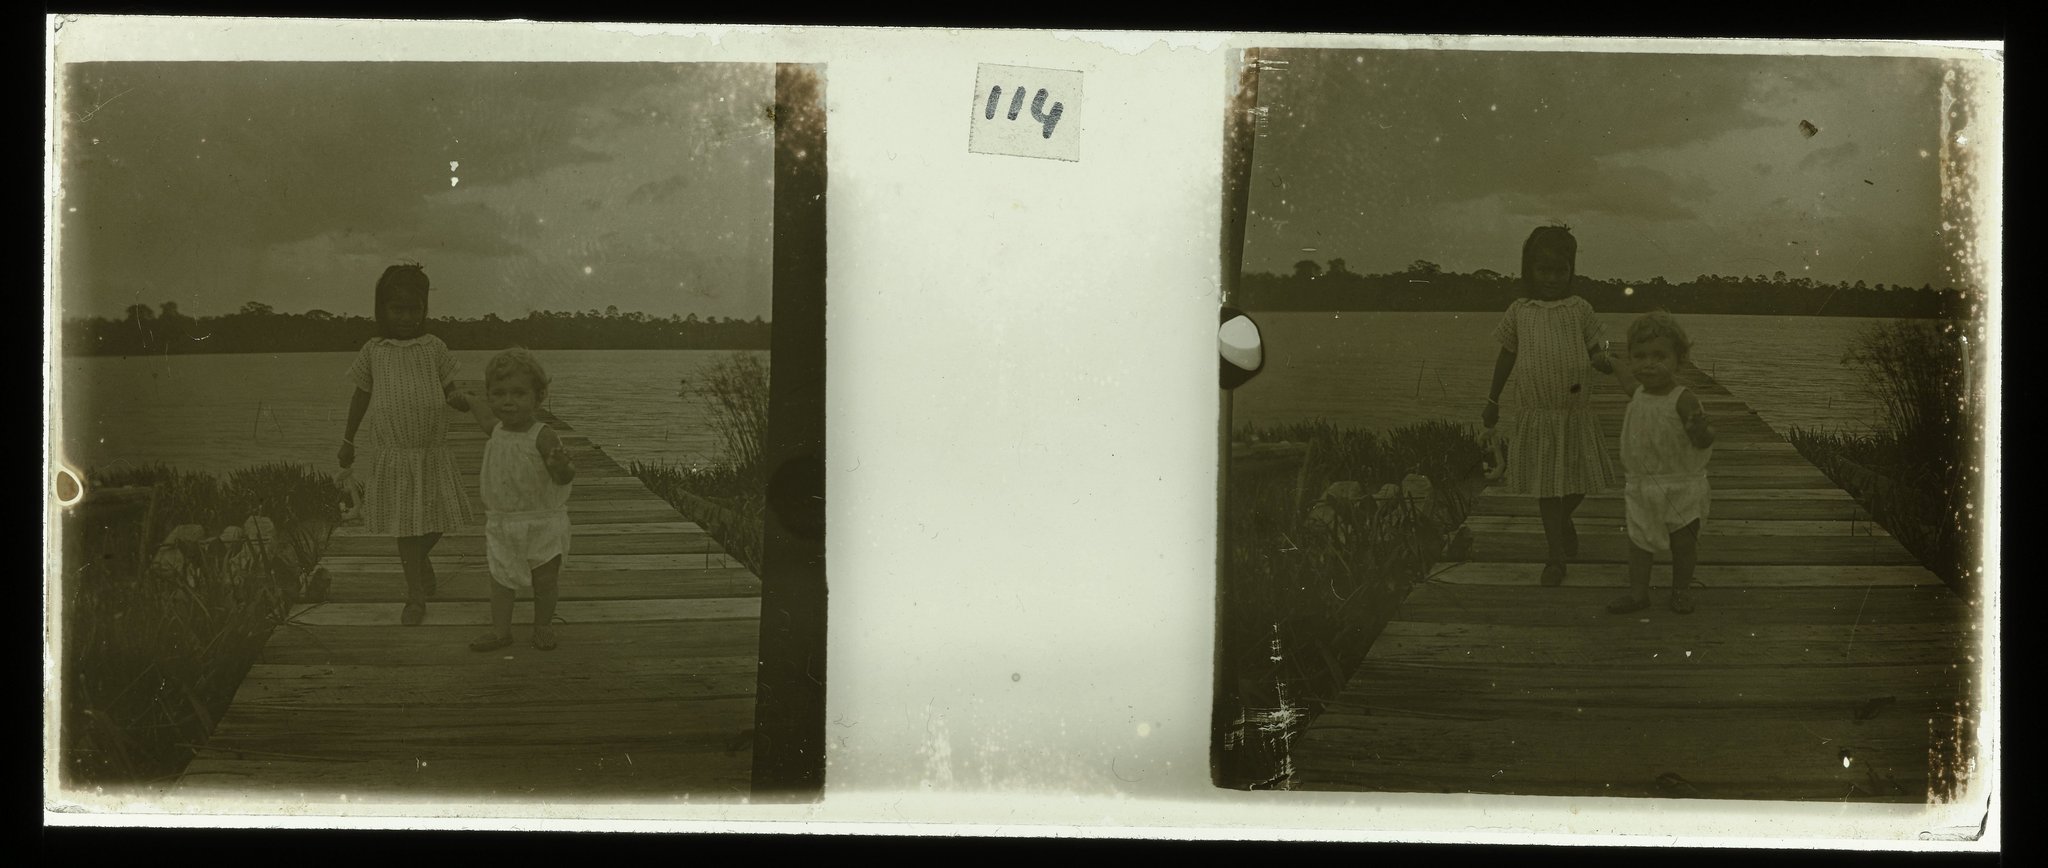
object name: stereograph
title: Gerard Brouwers en Paulina op de steiger van plantage Accaribo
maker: theodoor brouwers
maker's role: amateurfotograaf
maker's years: 1874-1932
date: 1913-1930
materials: glass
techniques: photography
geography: suriname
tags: amsterdam, theodoor brouwers, plantation, working class, labourers, suriname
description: In de periode 1911-1932 woonde op plantage Accaribo in Suriname de familie Brouwers van wie de foto's afkomstig zijn. Rond 1910 vond Theodoor Brouwers werk op plantage Accaribo. In 1929 werd hij eigenaar van de plantage. Op Accaribo werden in zijn tijd bananen geproduceerd en wat koffie.